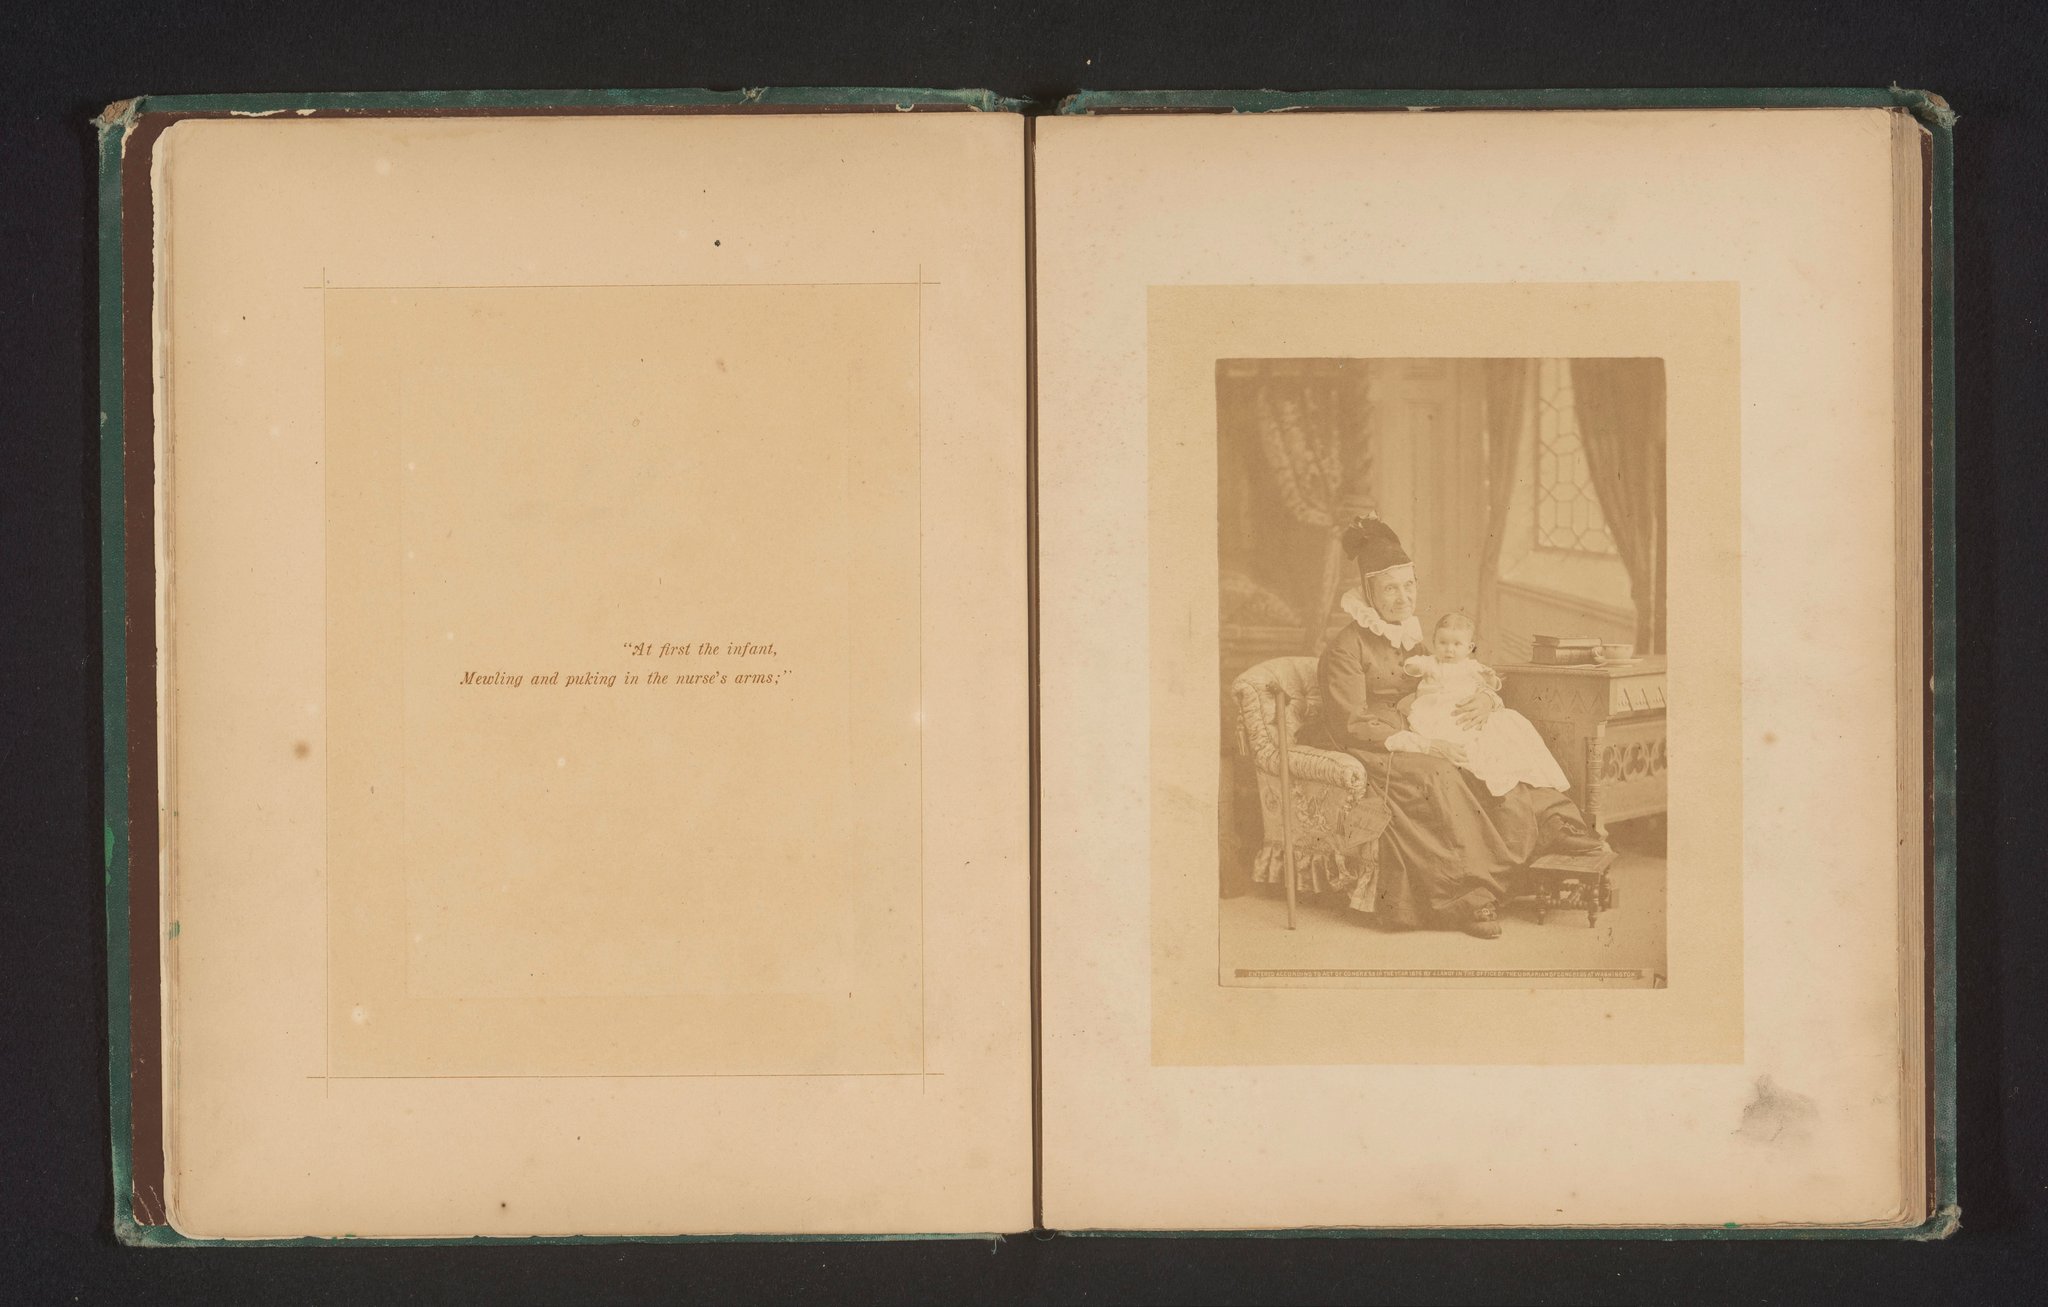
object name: photomechanical print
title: Het kind en de kinderjuffrouw uit The seven ages of man - As you like it van William Shakespeare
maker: james m. landy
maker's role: fotograaf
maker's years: 1838-1897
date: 1872-1877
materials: photographic support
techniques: autotype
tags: theatre, theatrical performance, historical persons, infant, baby